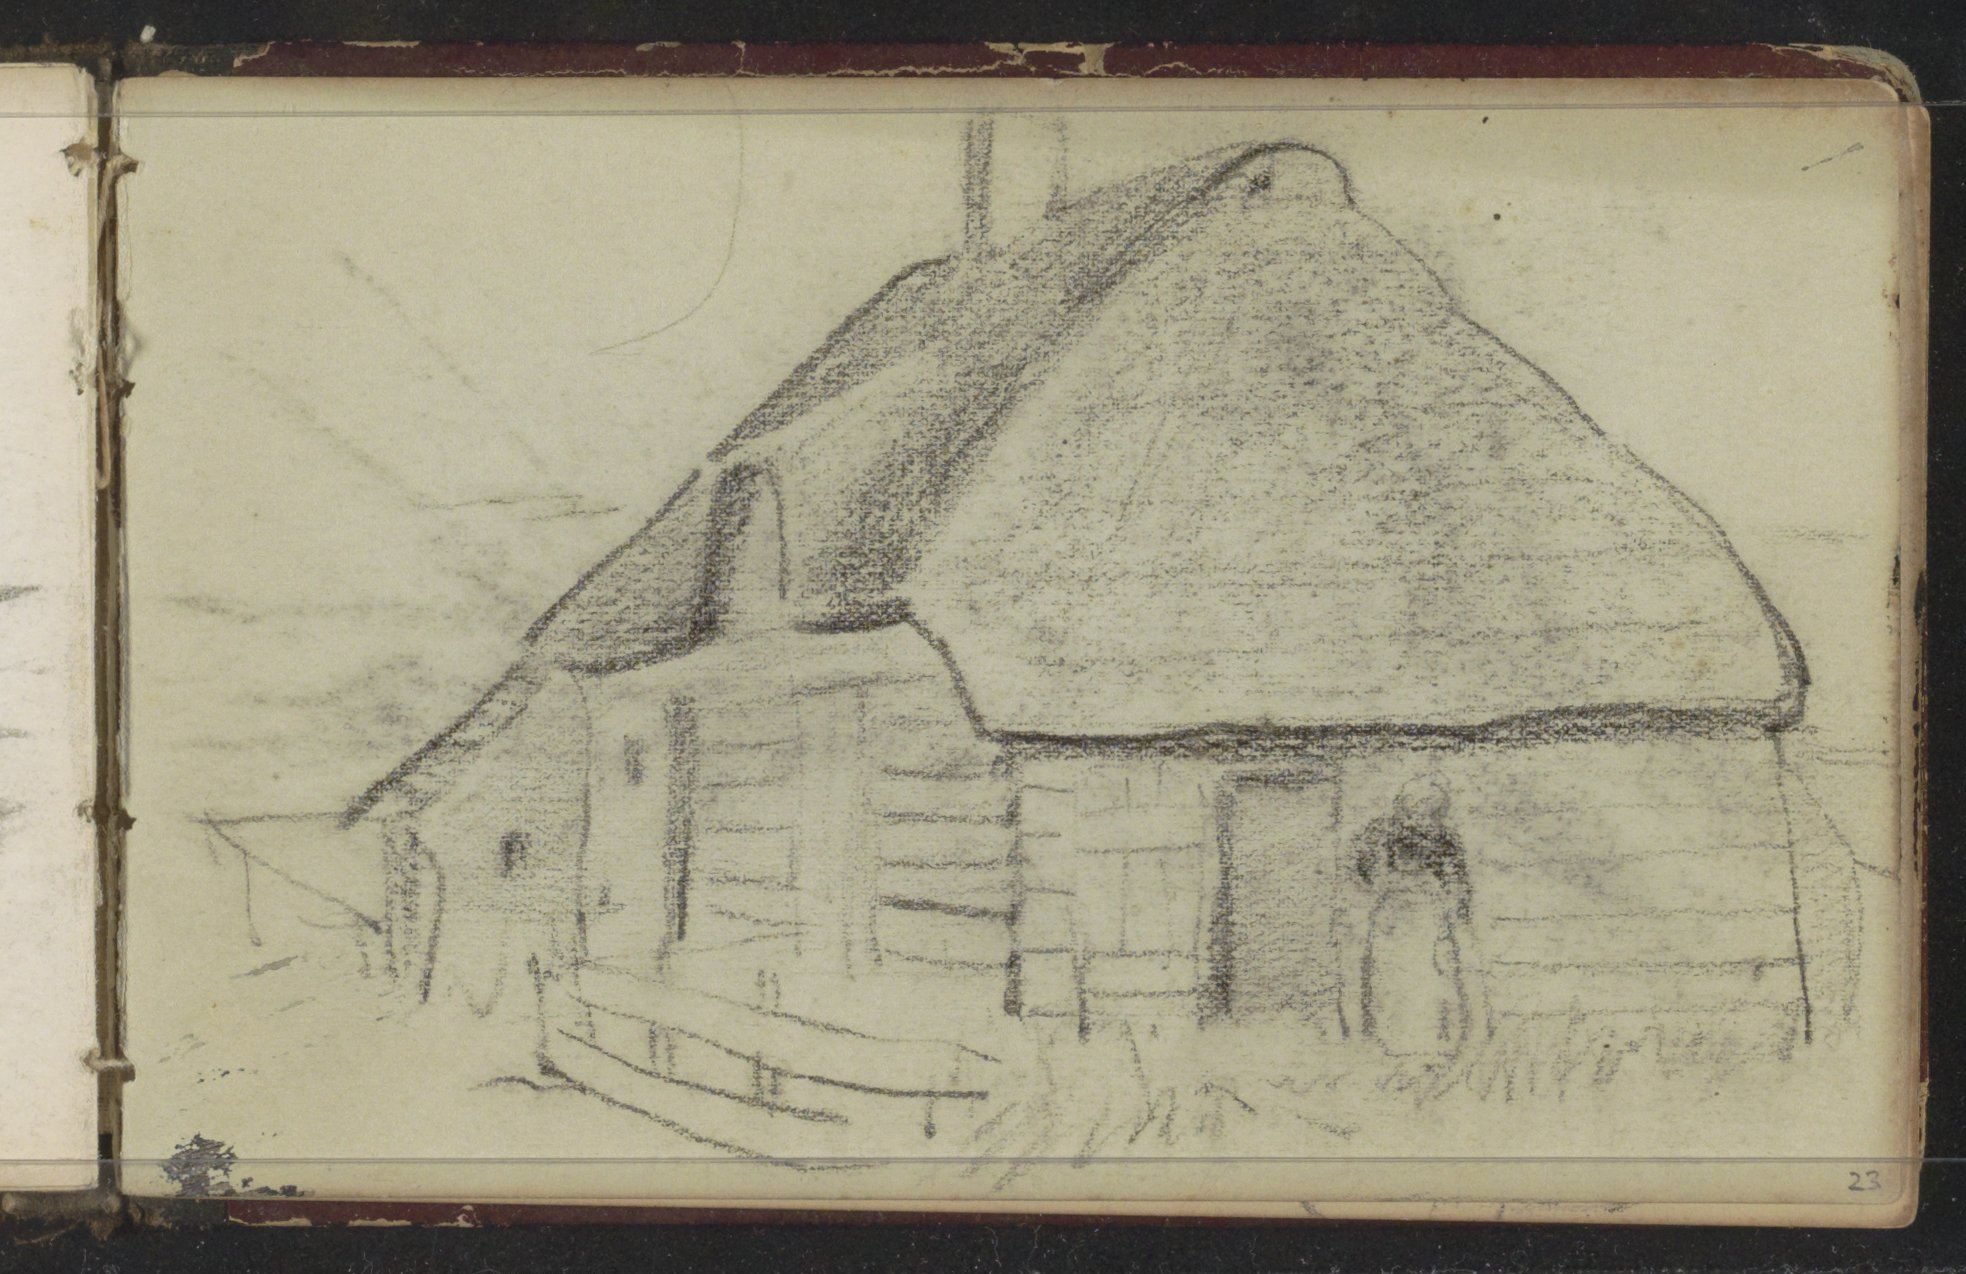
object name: sketchbook leaf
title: Boerderij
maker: willem cornelis rip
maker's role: draughtsman, painter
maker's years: 1856-1922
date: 1891-1892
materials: chalk, paper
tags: farm (building)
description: Blad 23 recto uit een schetsboek met 28 bladen.